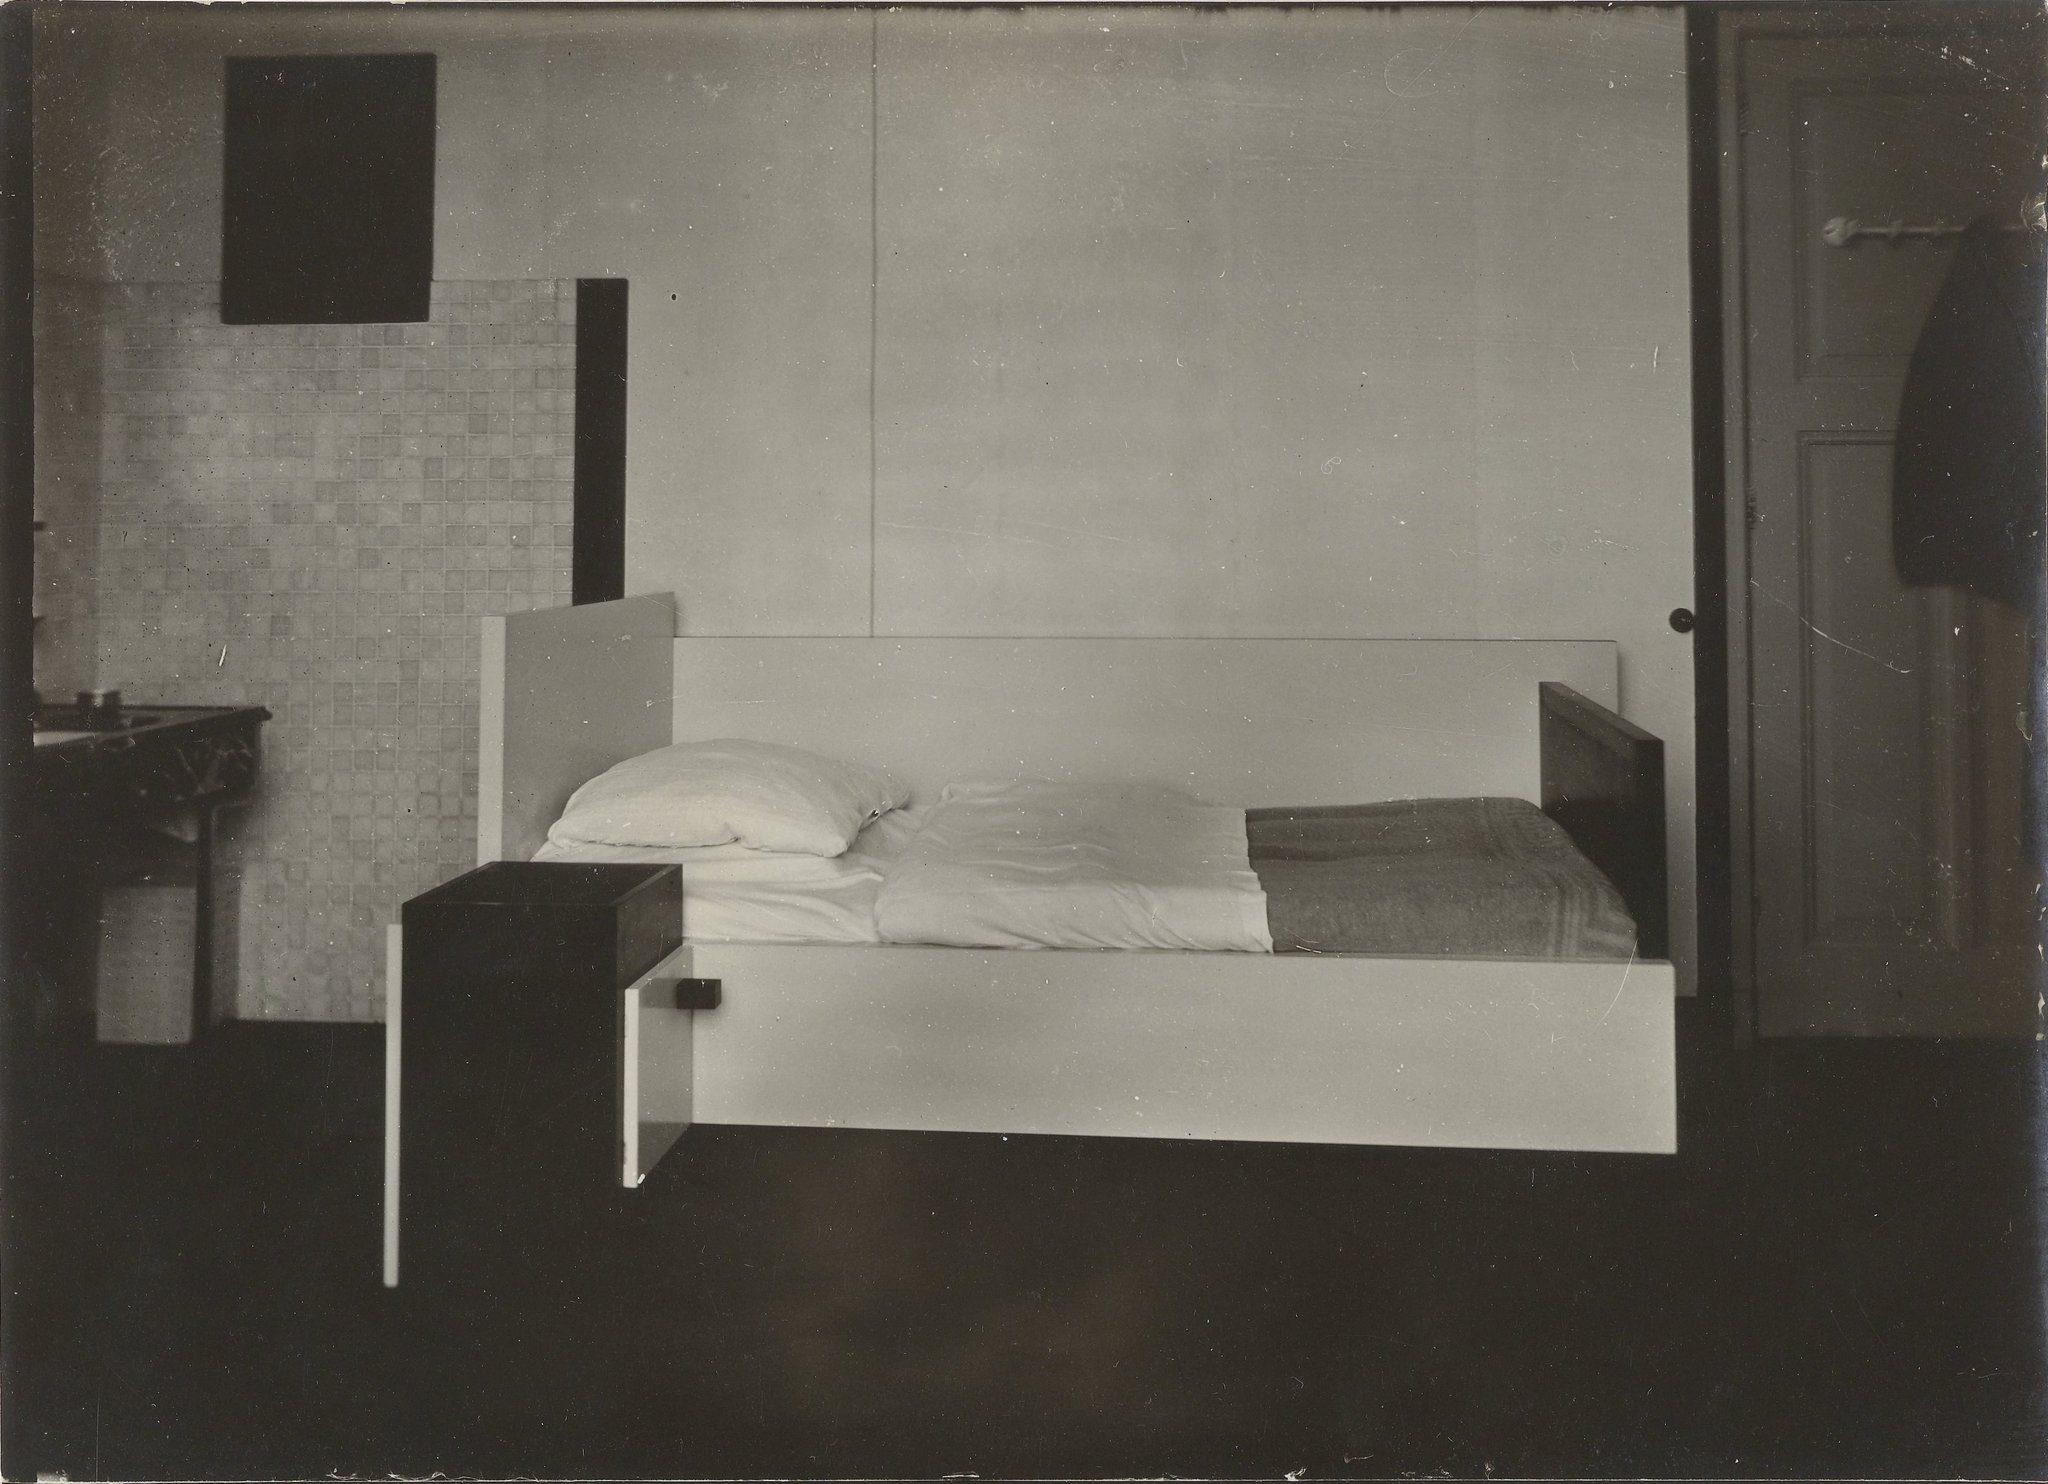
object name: photograph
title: Bedroom Suite Designed by Sybold van Ravesteyn for M.R. Radermacher Schorer's Home at No. 12 Wilhelminapark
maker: Anonymous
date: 1924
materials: paper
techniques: gelatin silver print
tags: utrecht, bed